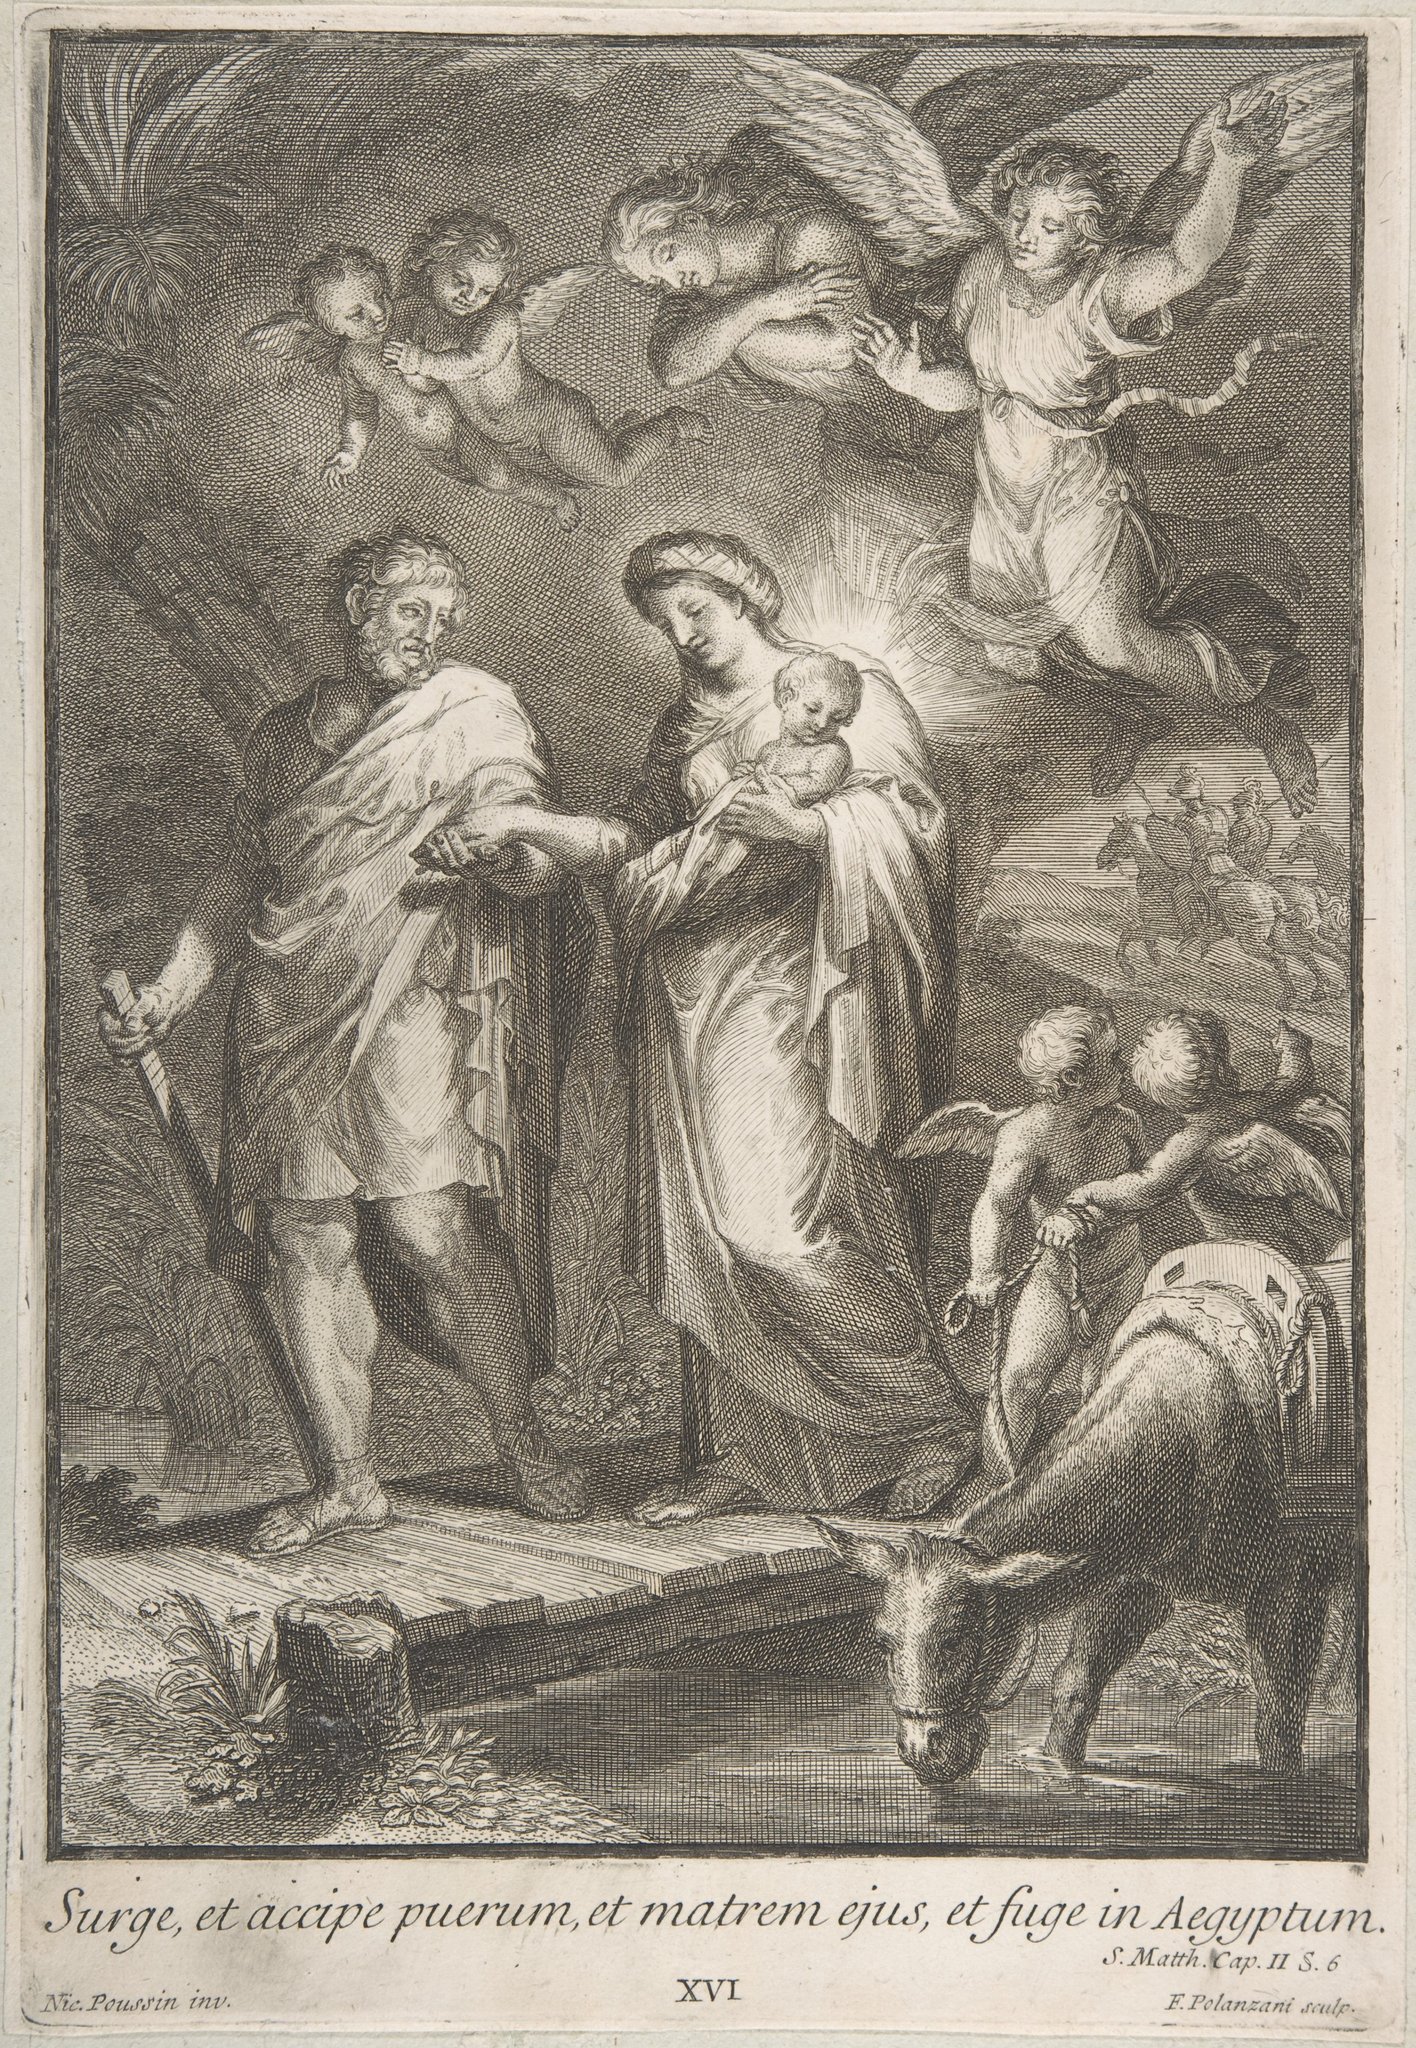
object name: print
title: The Flight into Egypt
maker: francesco polanzani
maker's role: artist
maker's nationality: italian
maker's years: 1700-1783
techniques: engraving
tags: donkeys,angels,madonna and child,saints